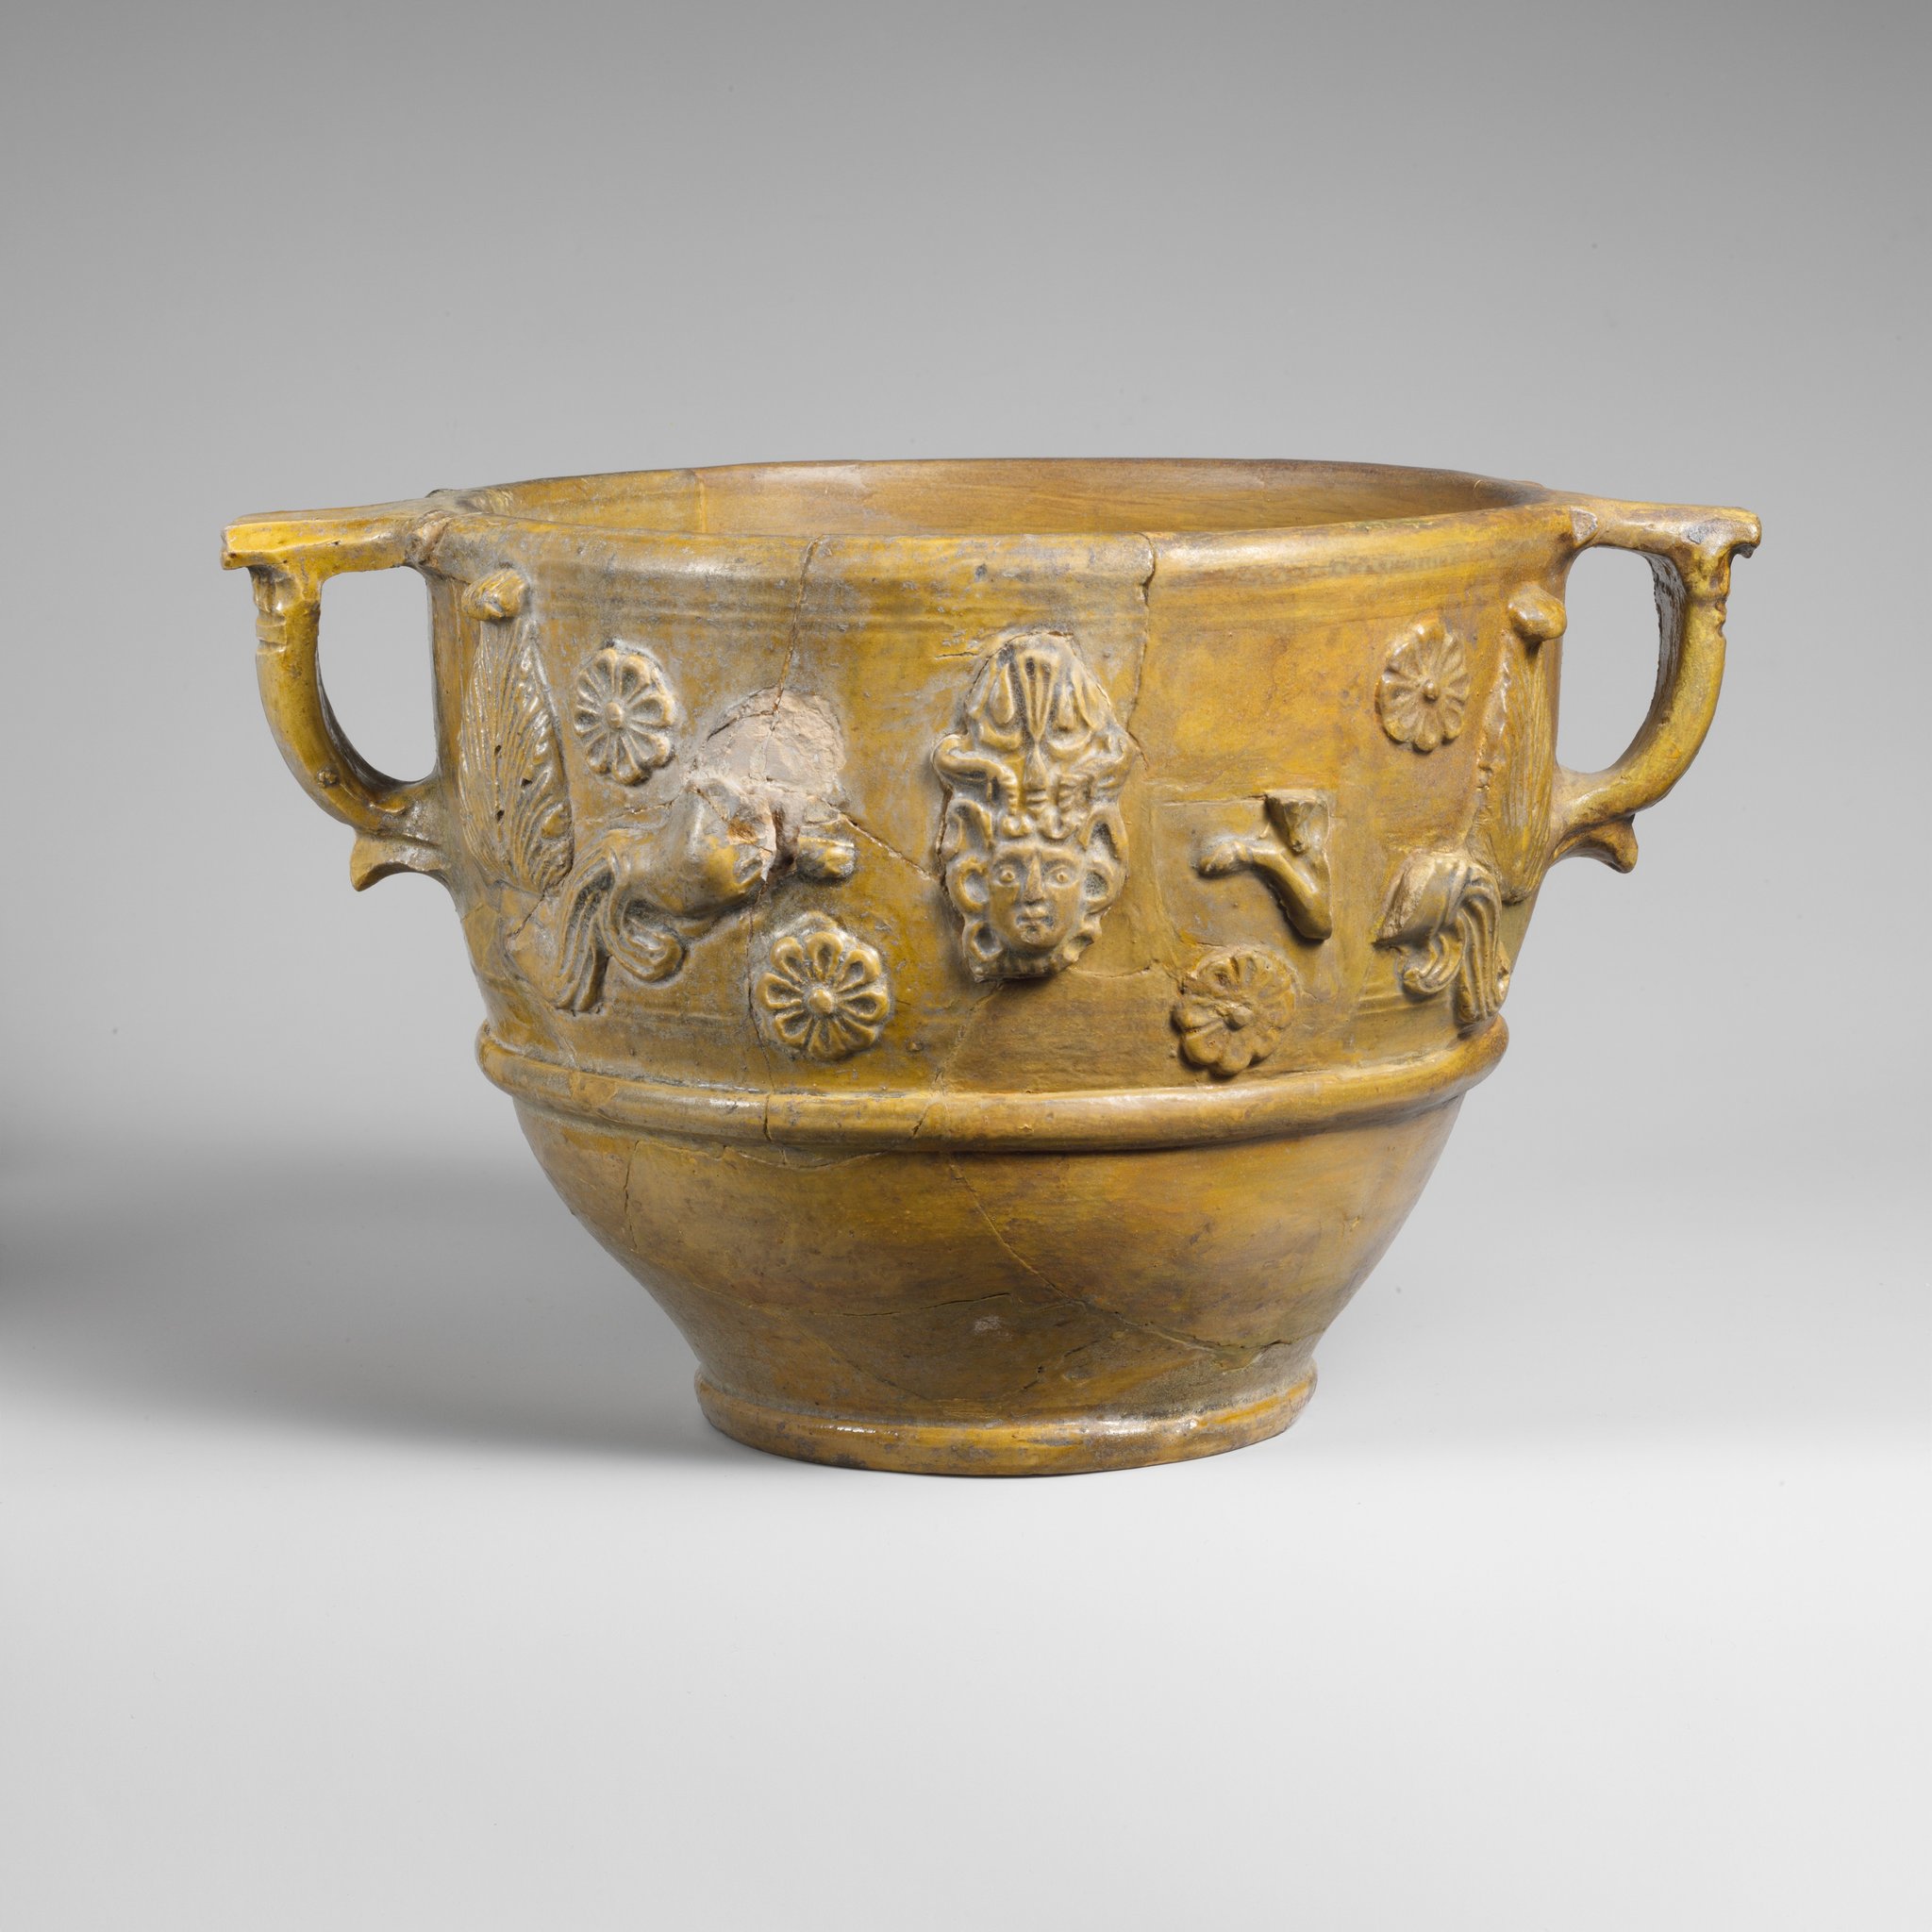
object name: skyphos fragment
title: Fragmentary terracotta scyphus (drinking cup)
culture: roman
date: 1-50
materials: terracotta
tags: heads,monsters